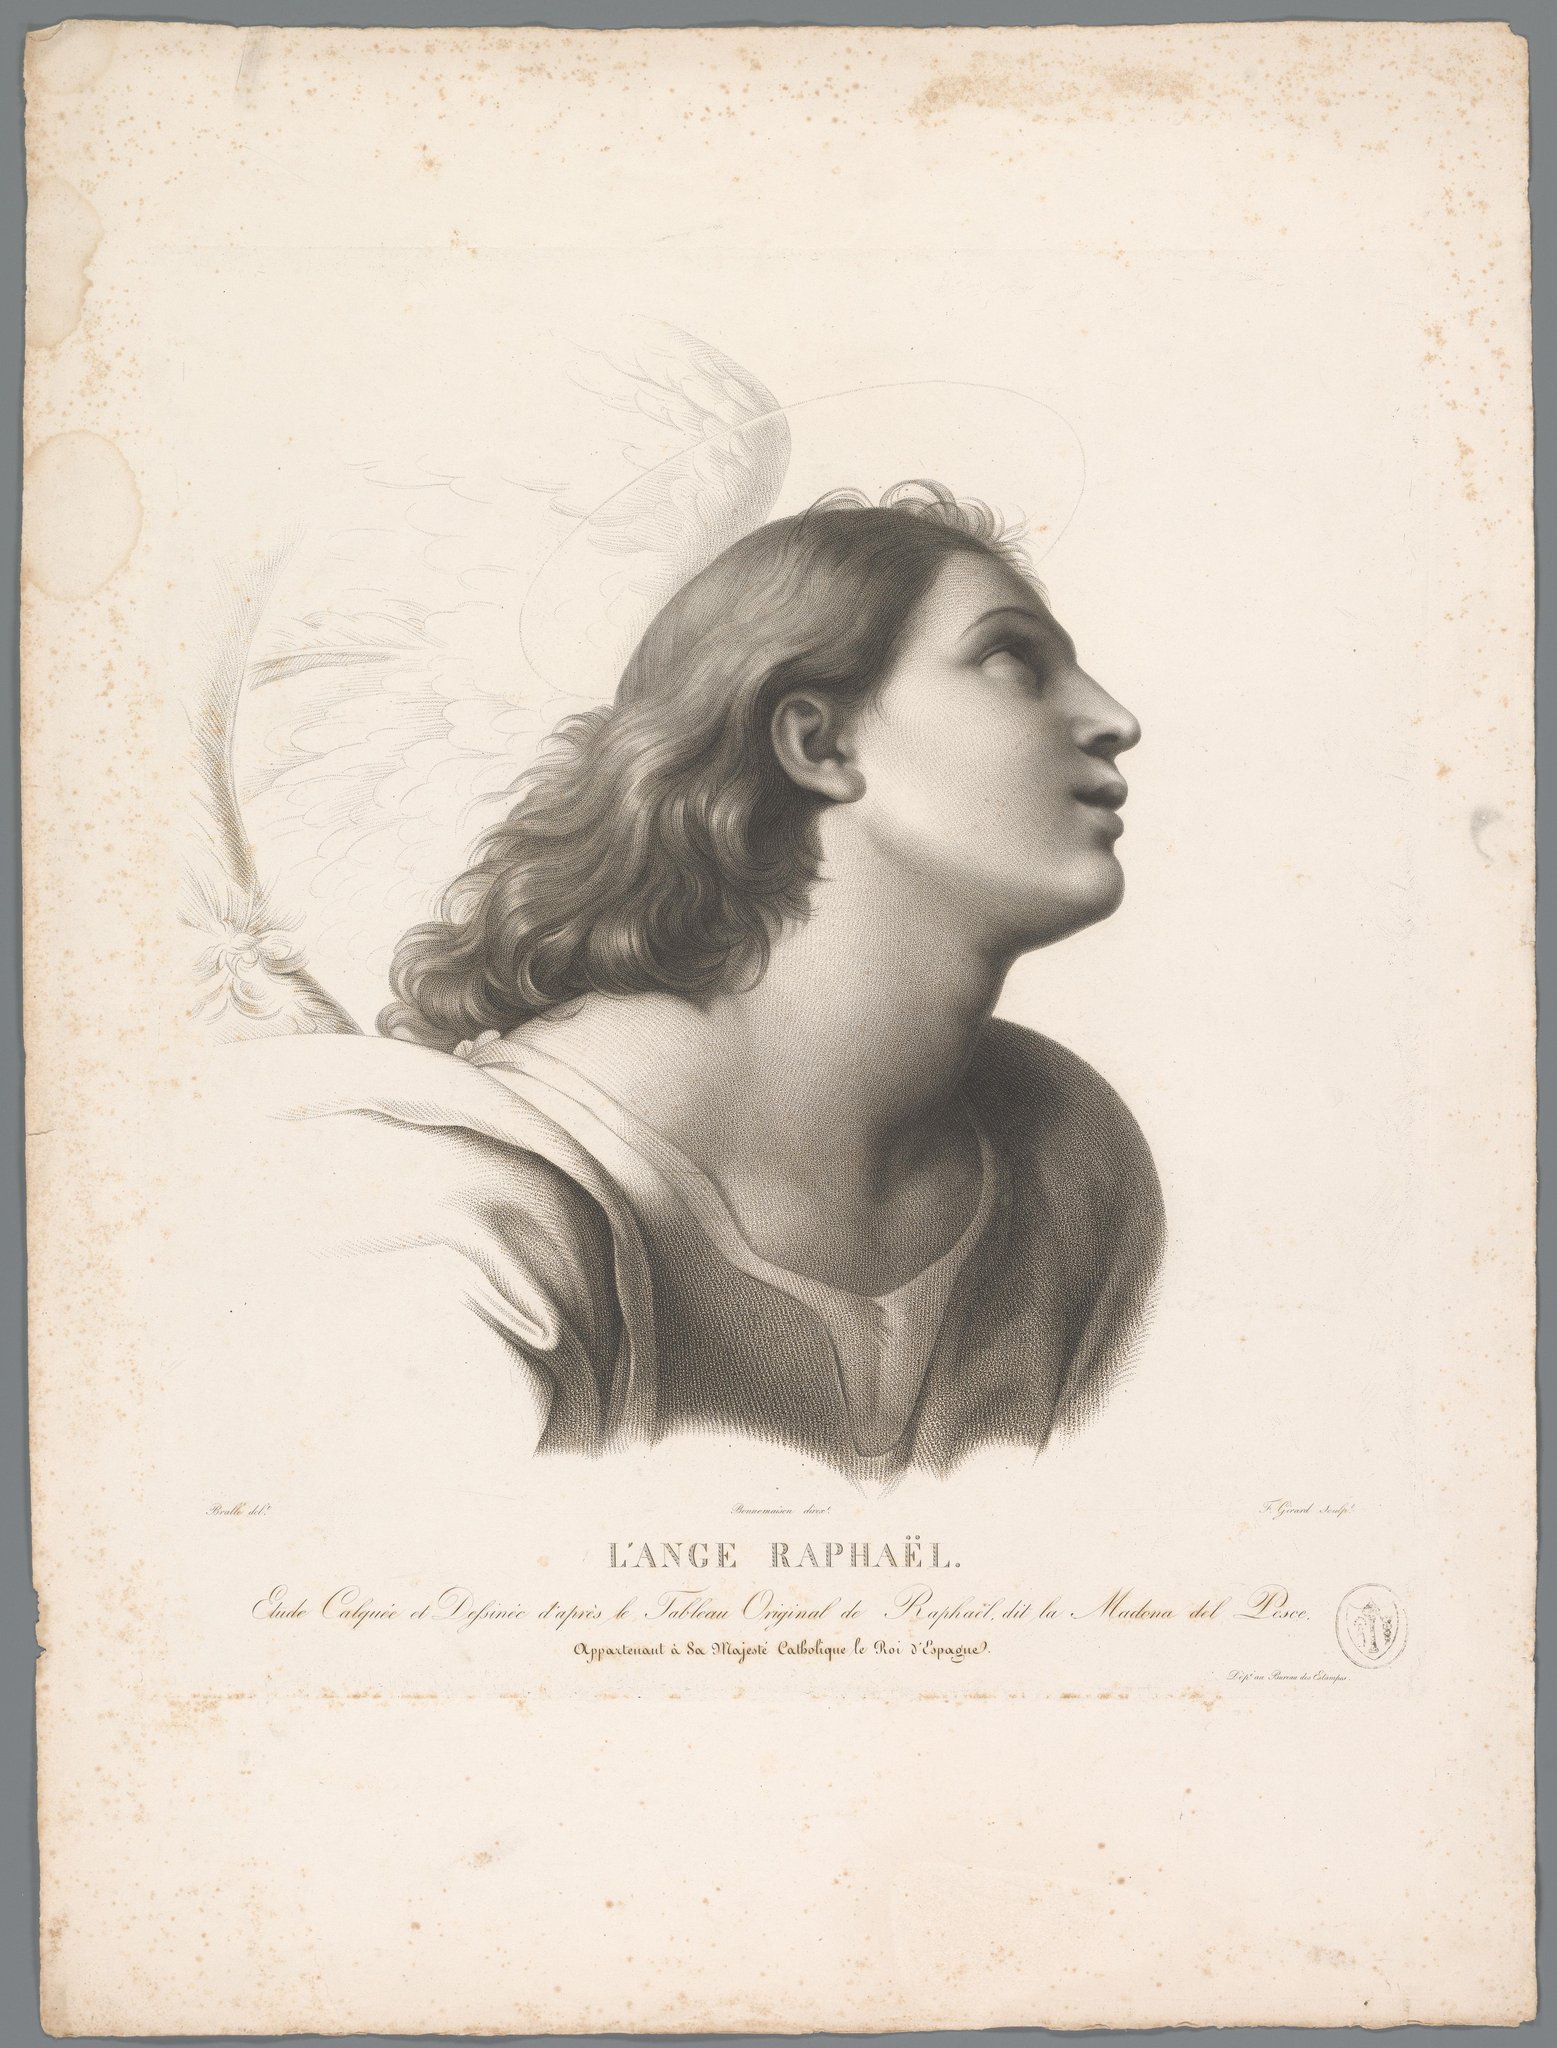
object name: print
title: Suite d'Études calquées et dessinées d'après Cinq Tableaux de Raphaël (...)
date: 1797-1870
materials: paper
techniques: printmaking, engraving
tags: the archangel raphael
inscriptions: collector's mark: Lugt 4583, : ‘Dépé au Bureau des Estampes’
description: Maakt deel uit van een omslag met 8 prenten en 5 tekstbladen naar details van schilderijen door Rafaël. De serie kwam tot stand onder toezicht van Féréol Bonnemaison en werd voorzien van tekst door Toussaint-Bernard Émeric-David. Het geheel werd uitgegeven door Féréol Bonnemaison en Mesdemoiselles Érard te Parijs en gedrukt door Pierre I Didot in 1818. Dit betreft een detail van Tobias en de engel bij Maria met kind en de H. Hieronymus, dat zich in de collectie van het Museo del Prado in Madrid, inv.nr. P000297, ook wel bekend als de 'Madonna del Pesce'.